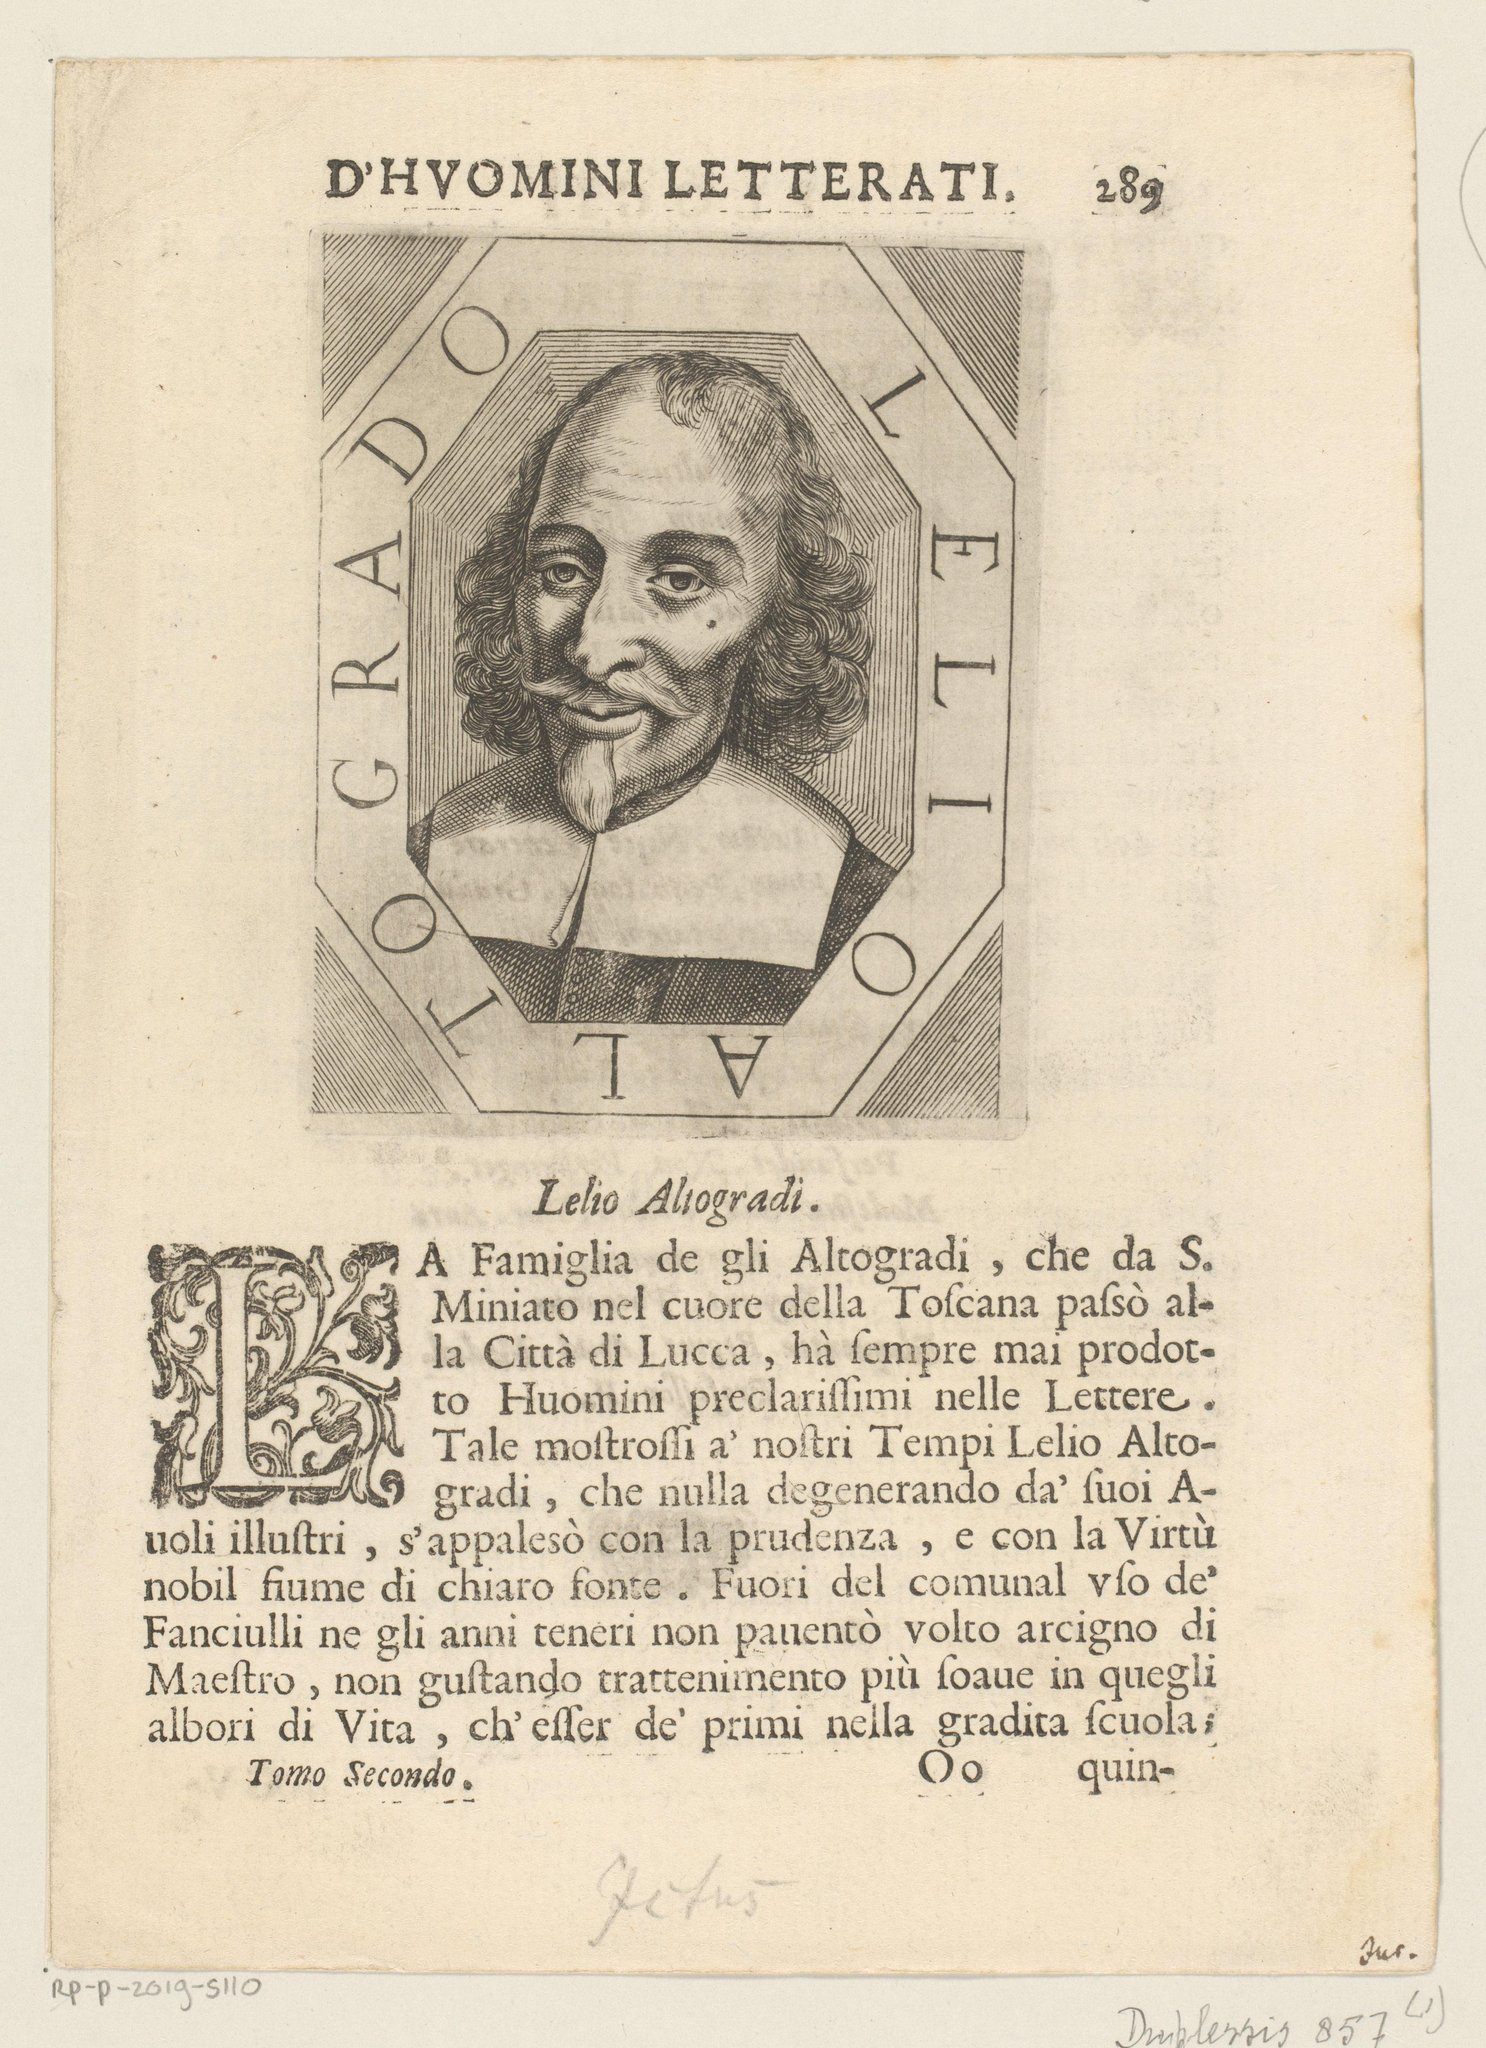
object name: print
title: Lelio Altogrado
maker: Anonymous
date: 1666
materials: paper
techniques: engraving, letterpress printing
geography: venice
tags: historical persons, writer, poet, author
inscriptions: inscription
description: Prent uit: Crasso, Lorenzo. Elogii degli huomini letterati scritti. Venetië: Combi & la Noù, 1666, dl. 2, p. 289.